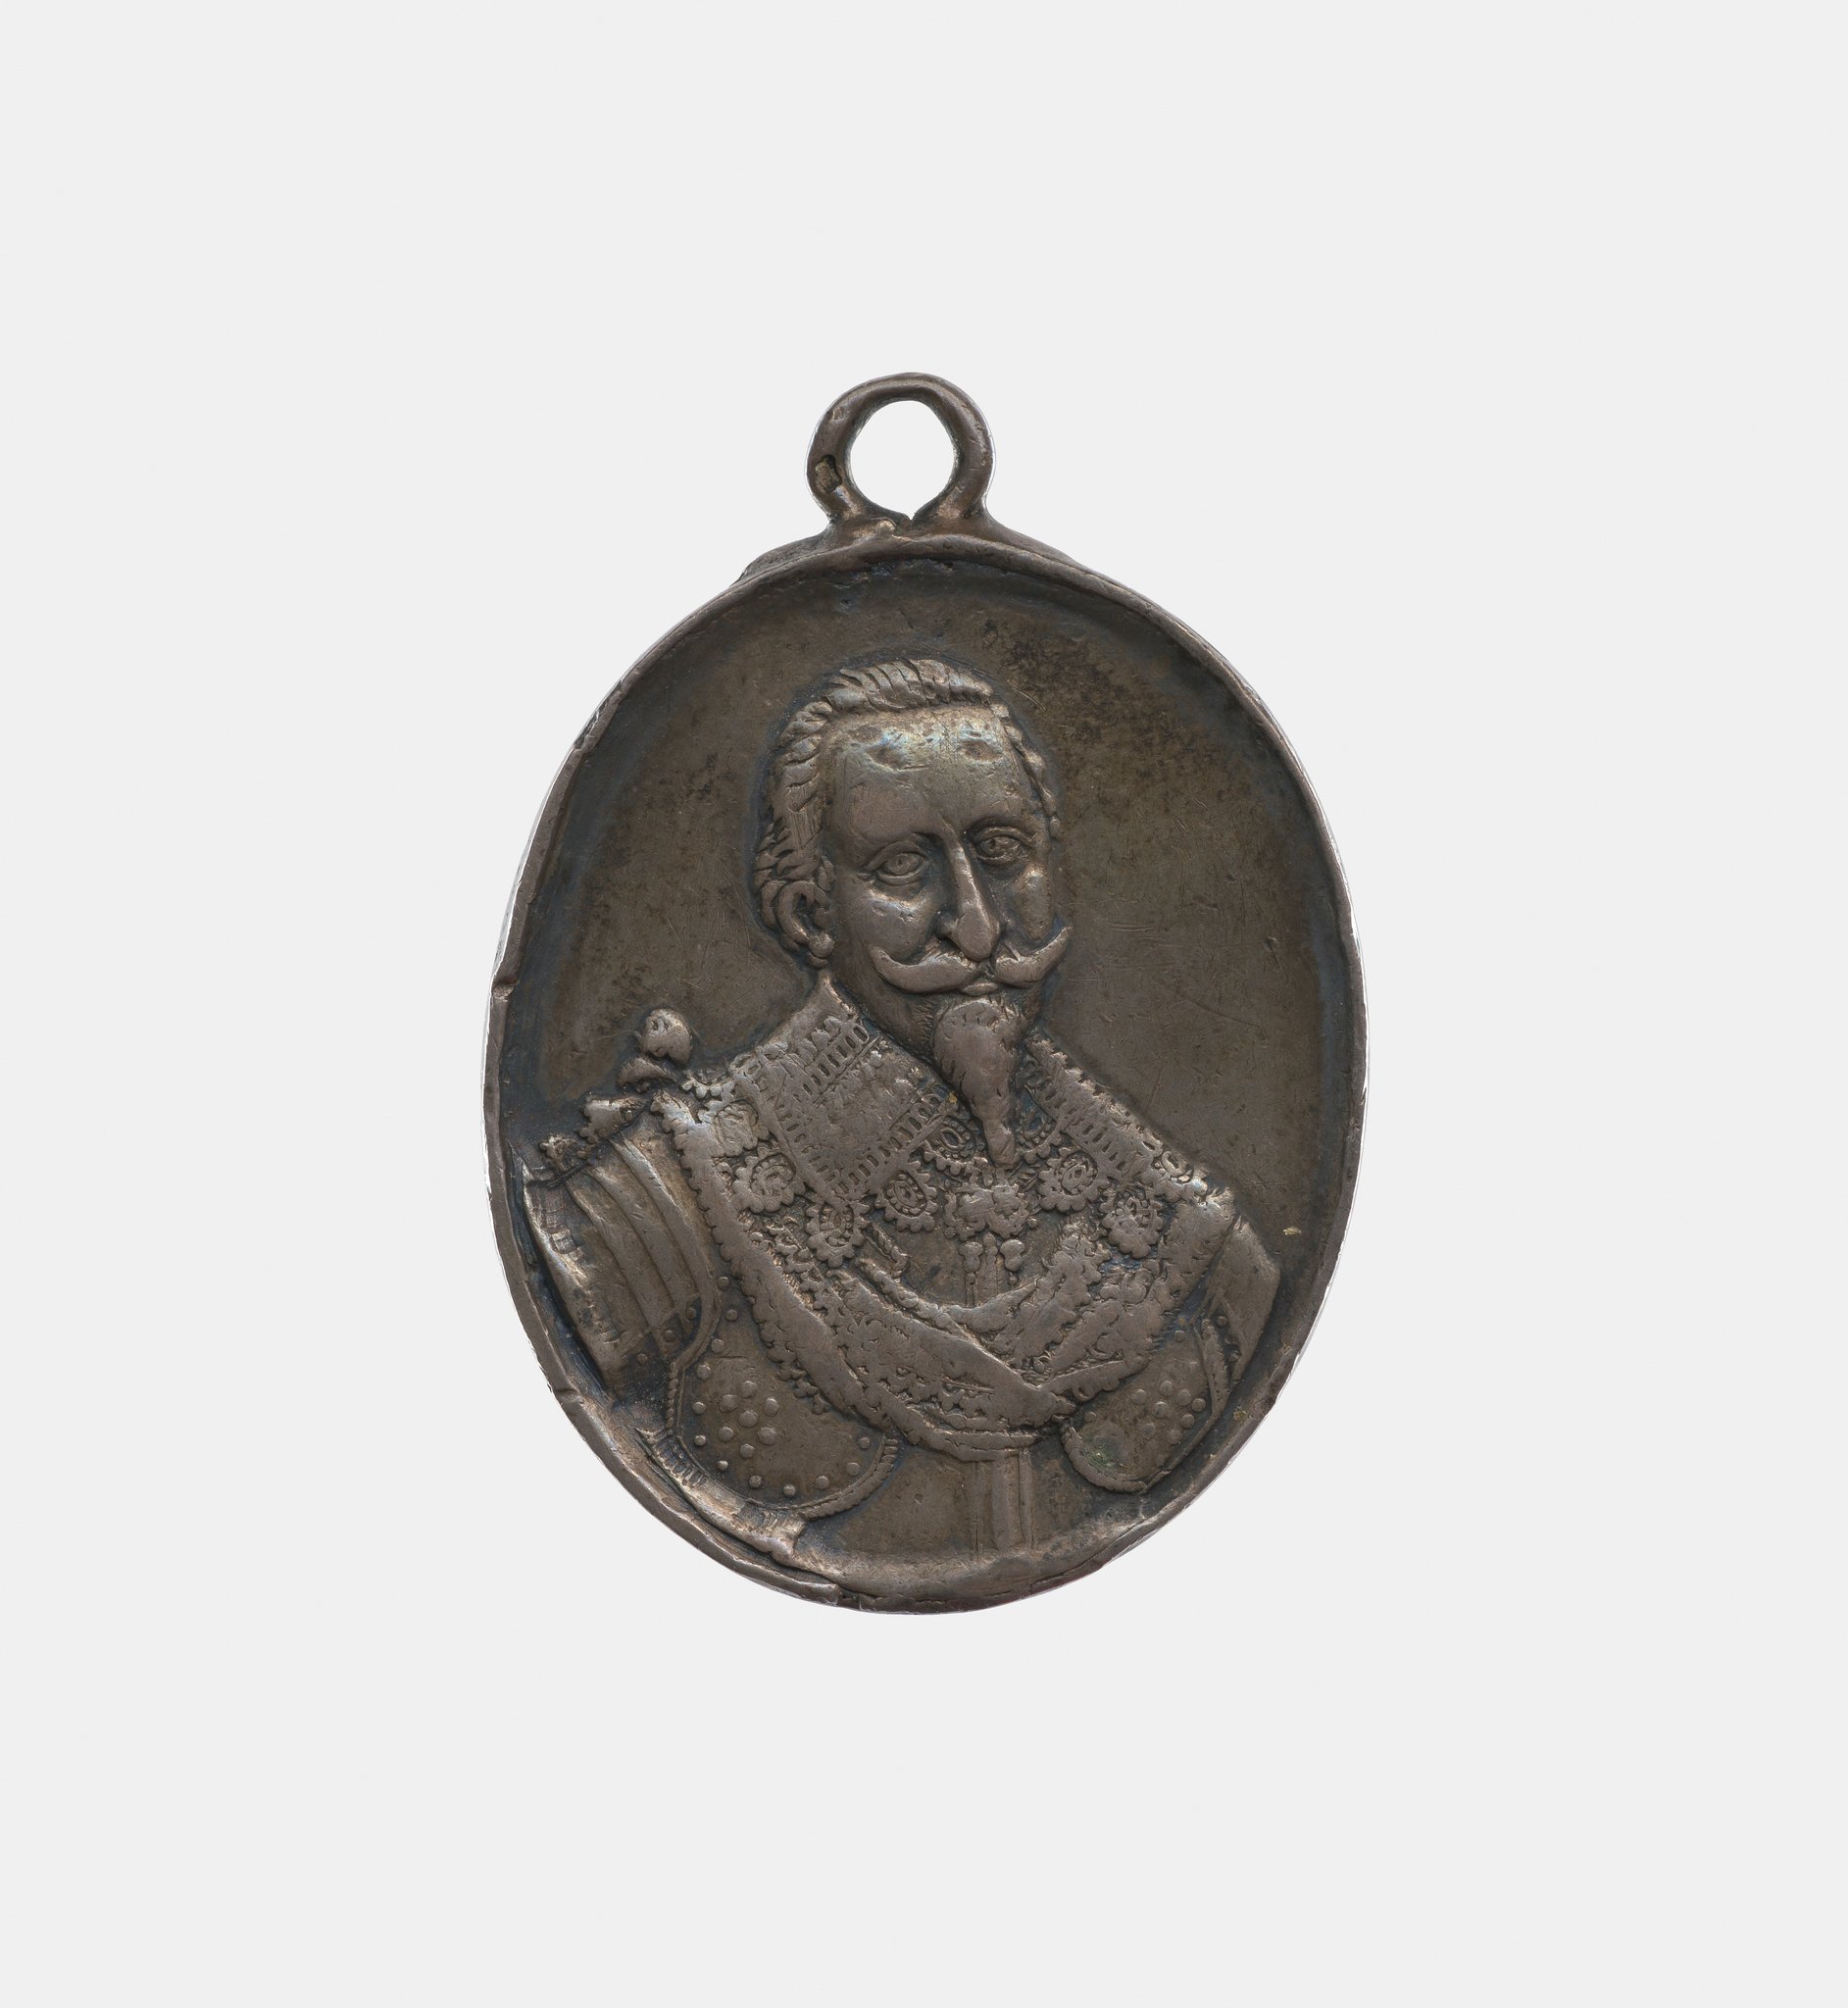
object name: medal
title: Gustavus Adolphus, King of Sweden (r. 1611–1632)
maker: Anonymous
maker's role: artist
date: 1611-1632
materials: silver